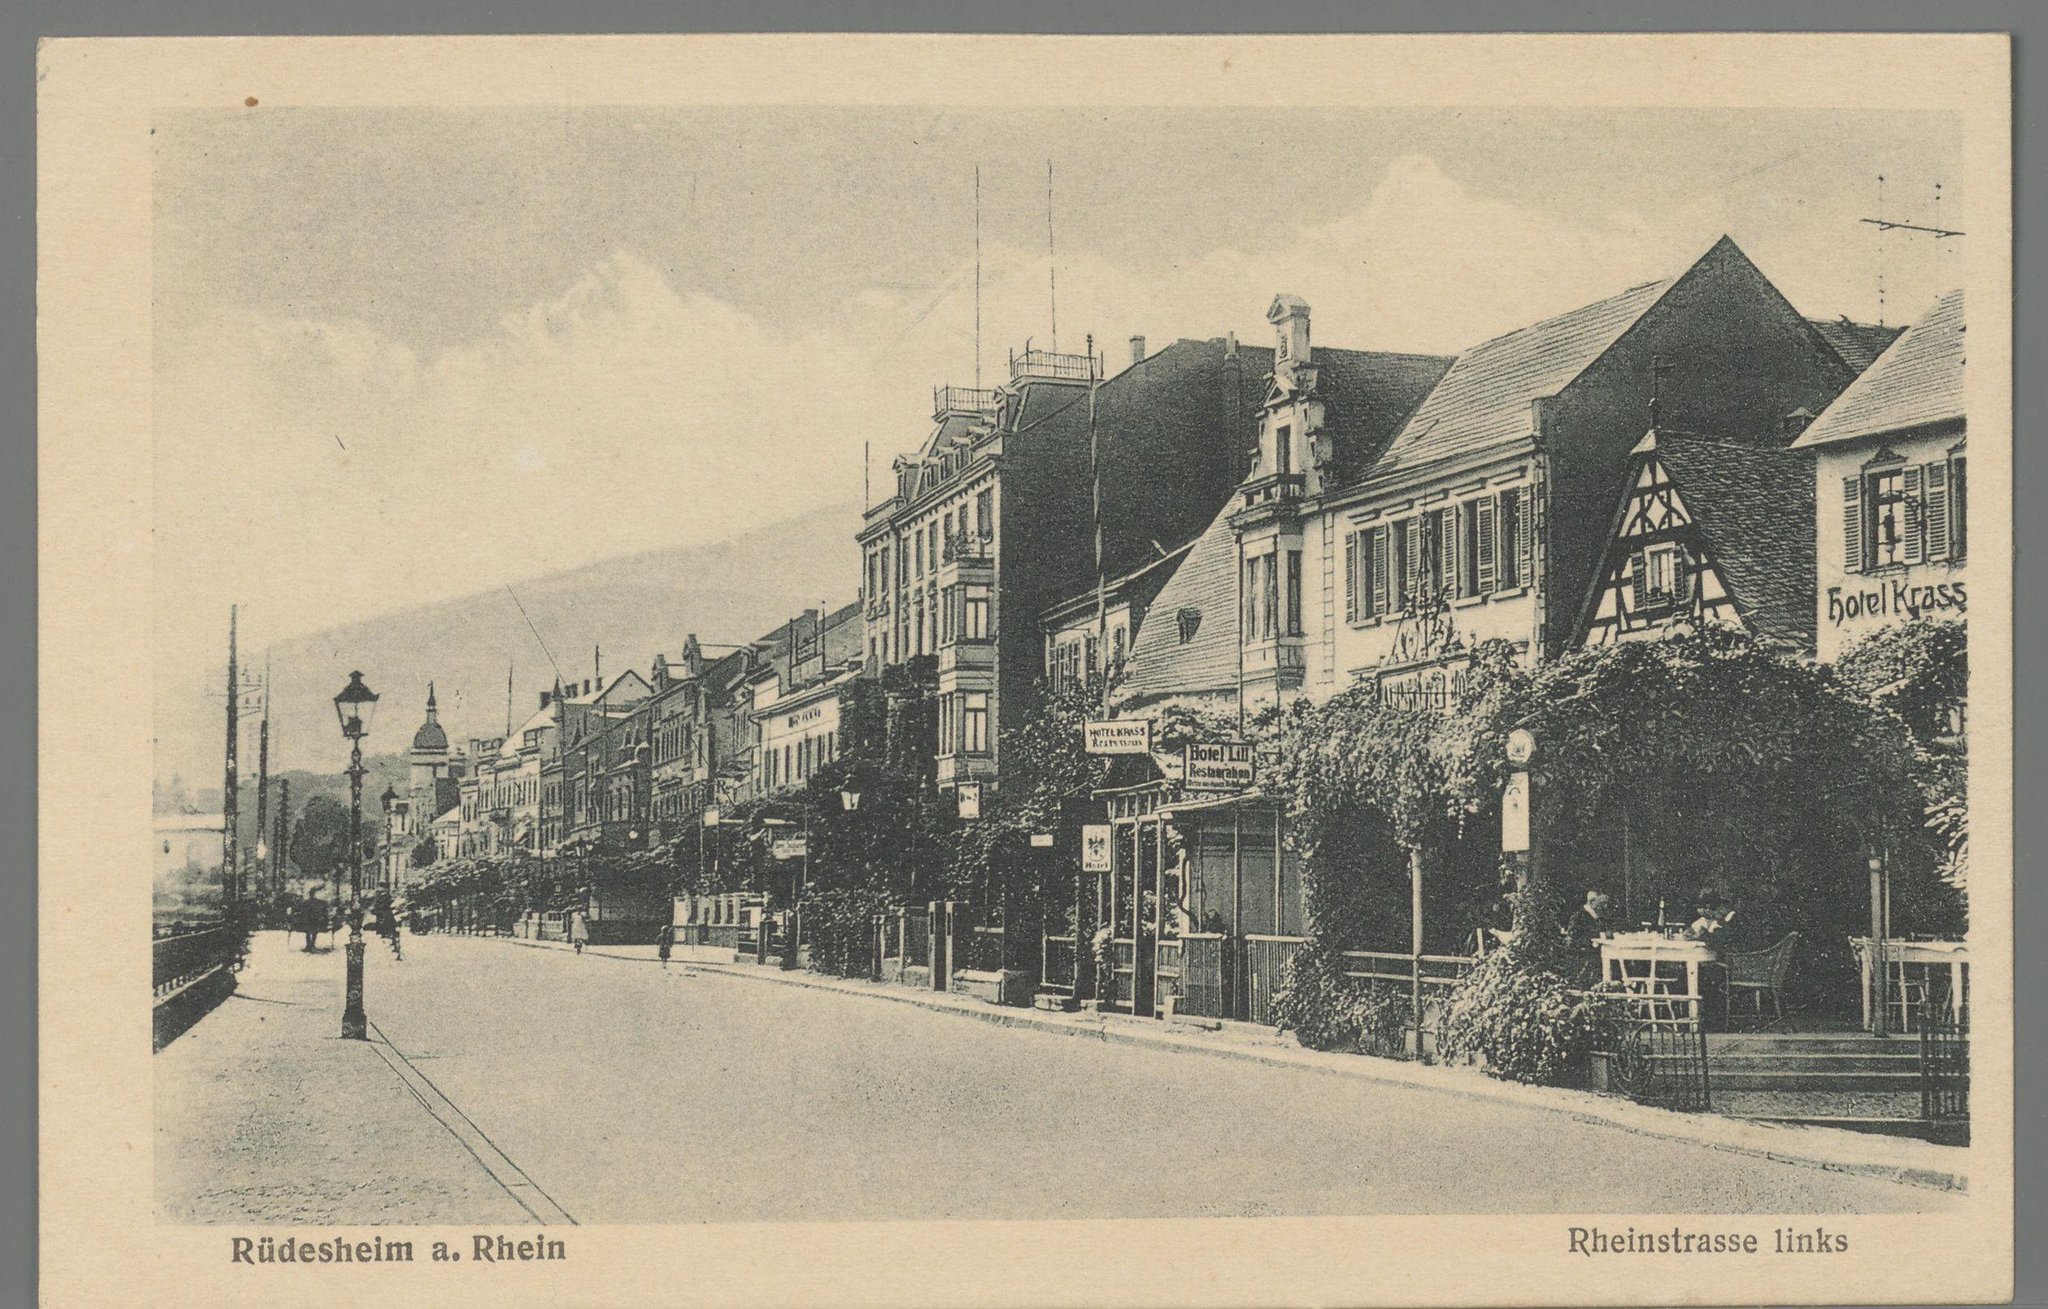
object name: photomechanical print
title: Rüdesheim a. Rhein. Rheinstrasse links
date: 1905-1925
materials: cardboard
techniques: photograph, writing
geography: mainz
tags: street